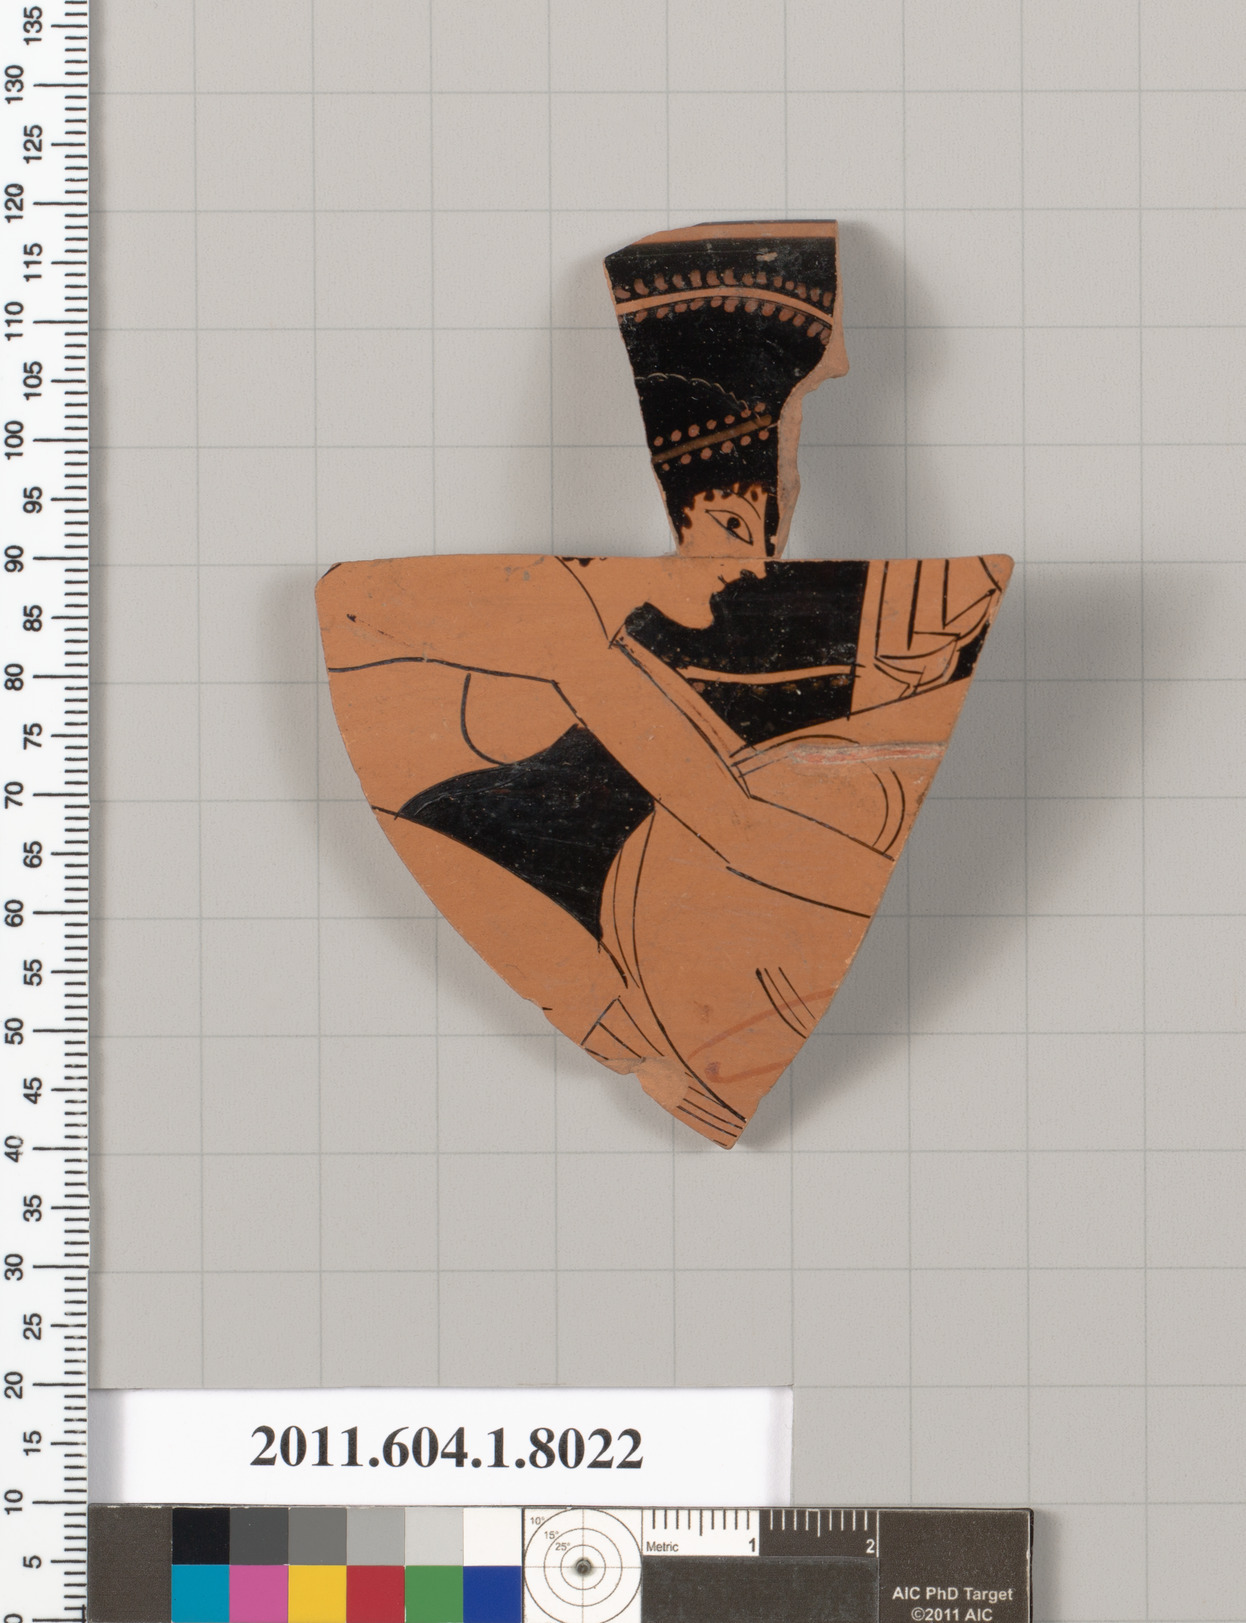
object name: kylix fragment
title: Terracotta rim fragment of a kylix (drinking cup)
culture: greek, attic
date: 510-500 BCE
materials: terracotta